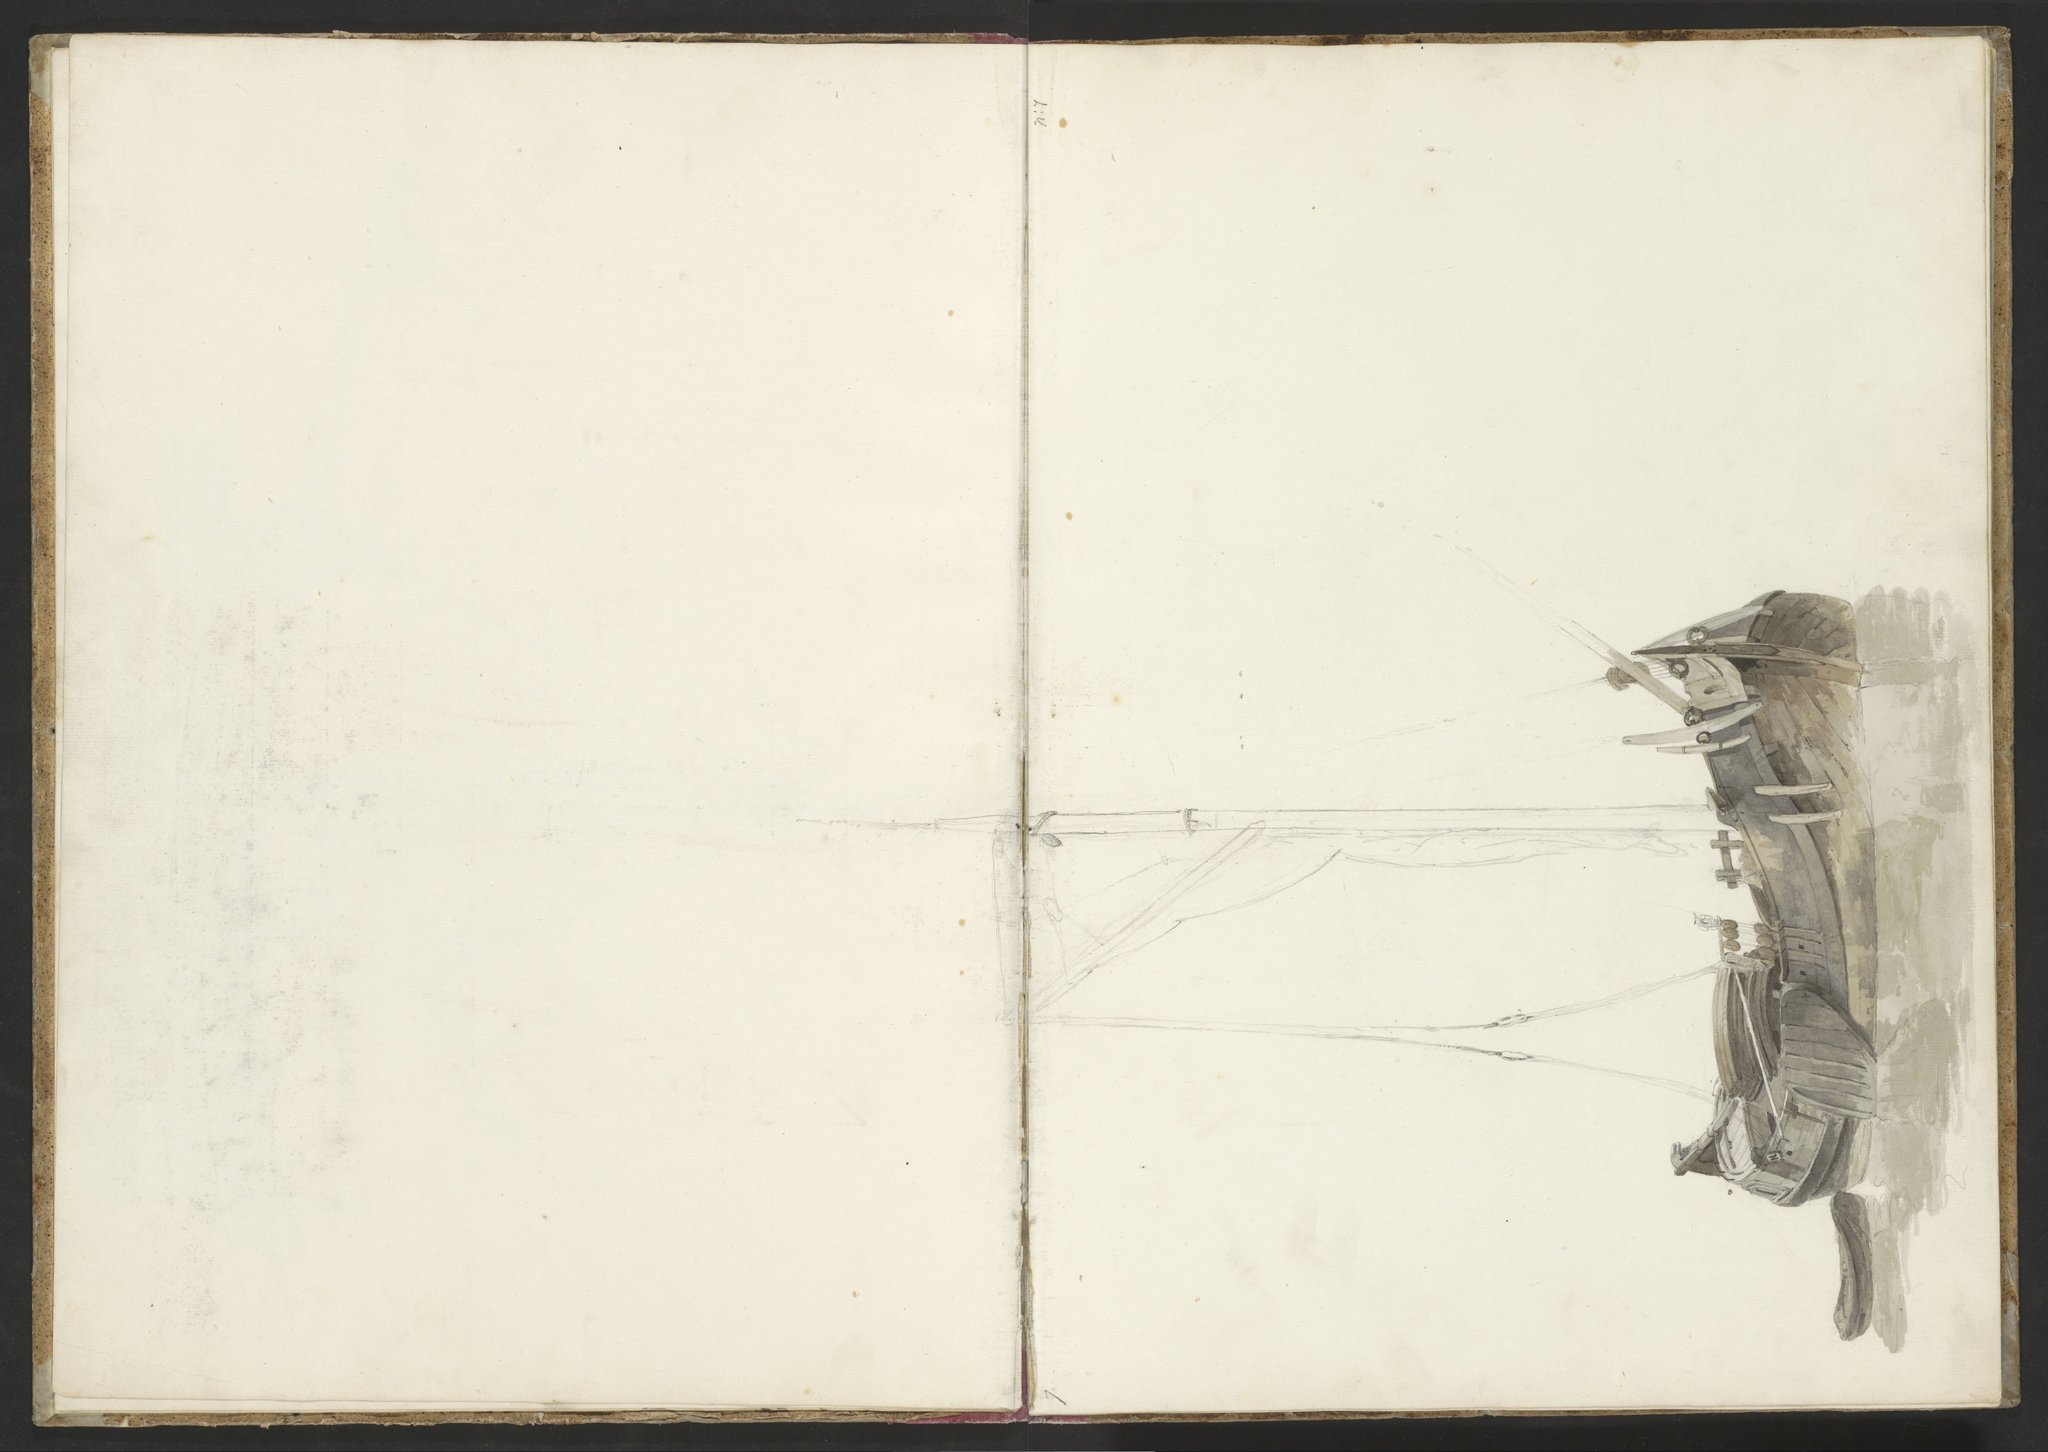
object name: sketchbook leaf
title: Zeilschip op het water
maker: johannes christiaan schotel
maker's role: draughtsman, painter, print maker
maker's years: 1787-1838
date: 1797-1838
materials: paper, pencil, watercolor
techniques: brush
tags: sailing-ship, sailing-boat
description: Blad 6 verso en 7 recto uit een schetsboek met 65 bladen.